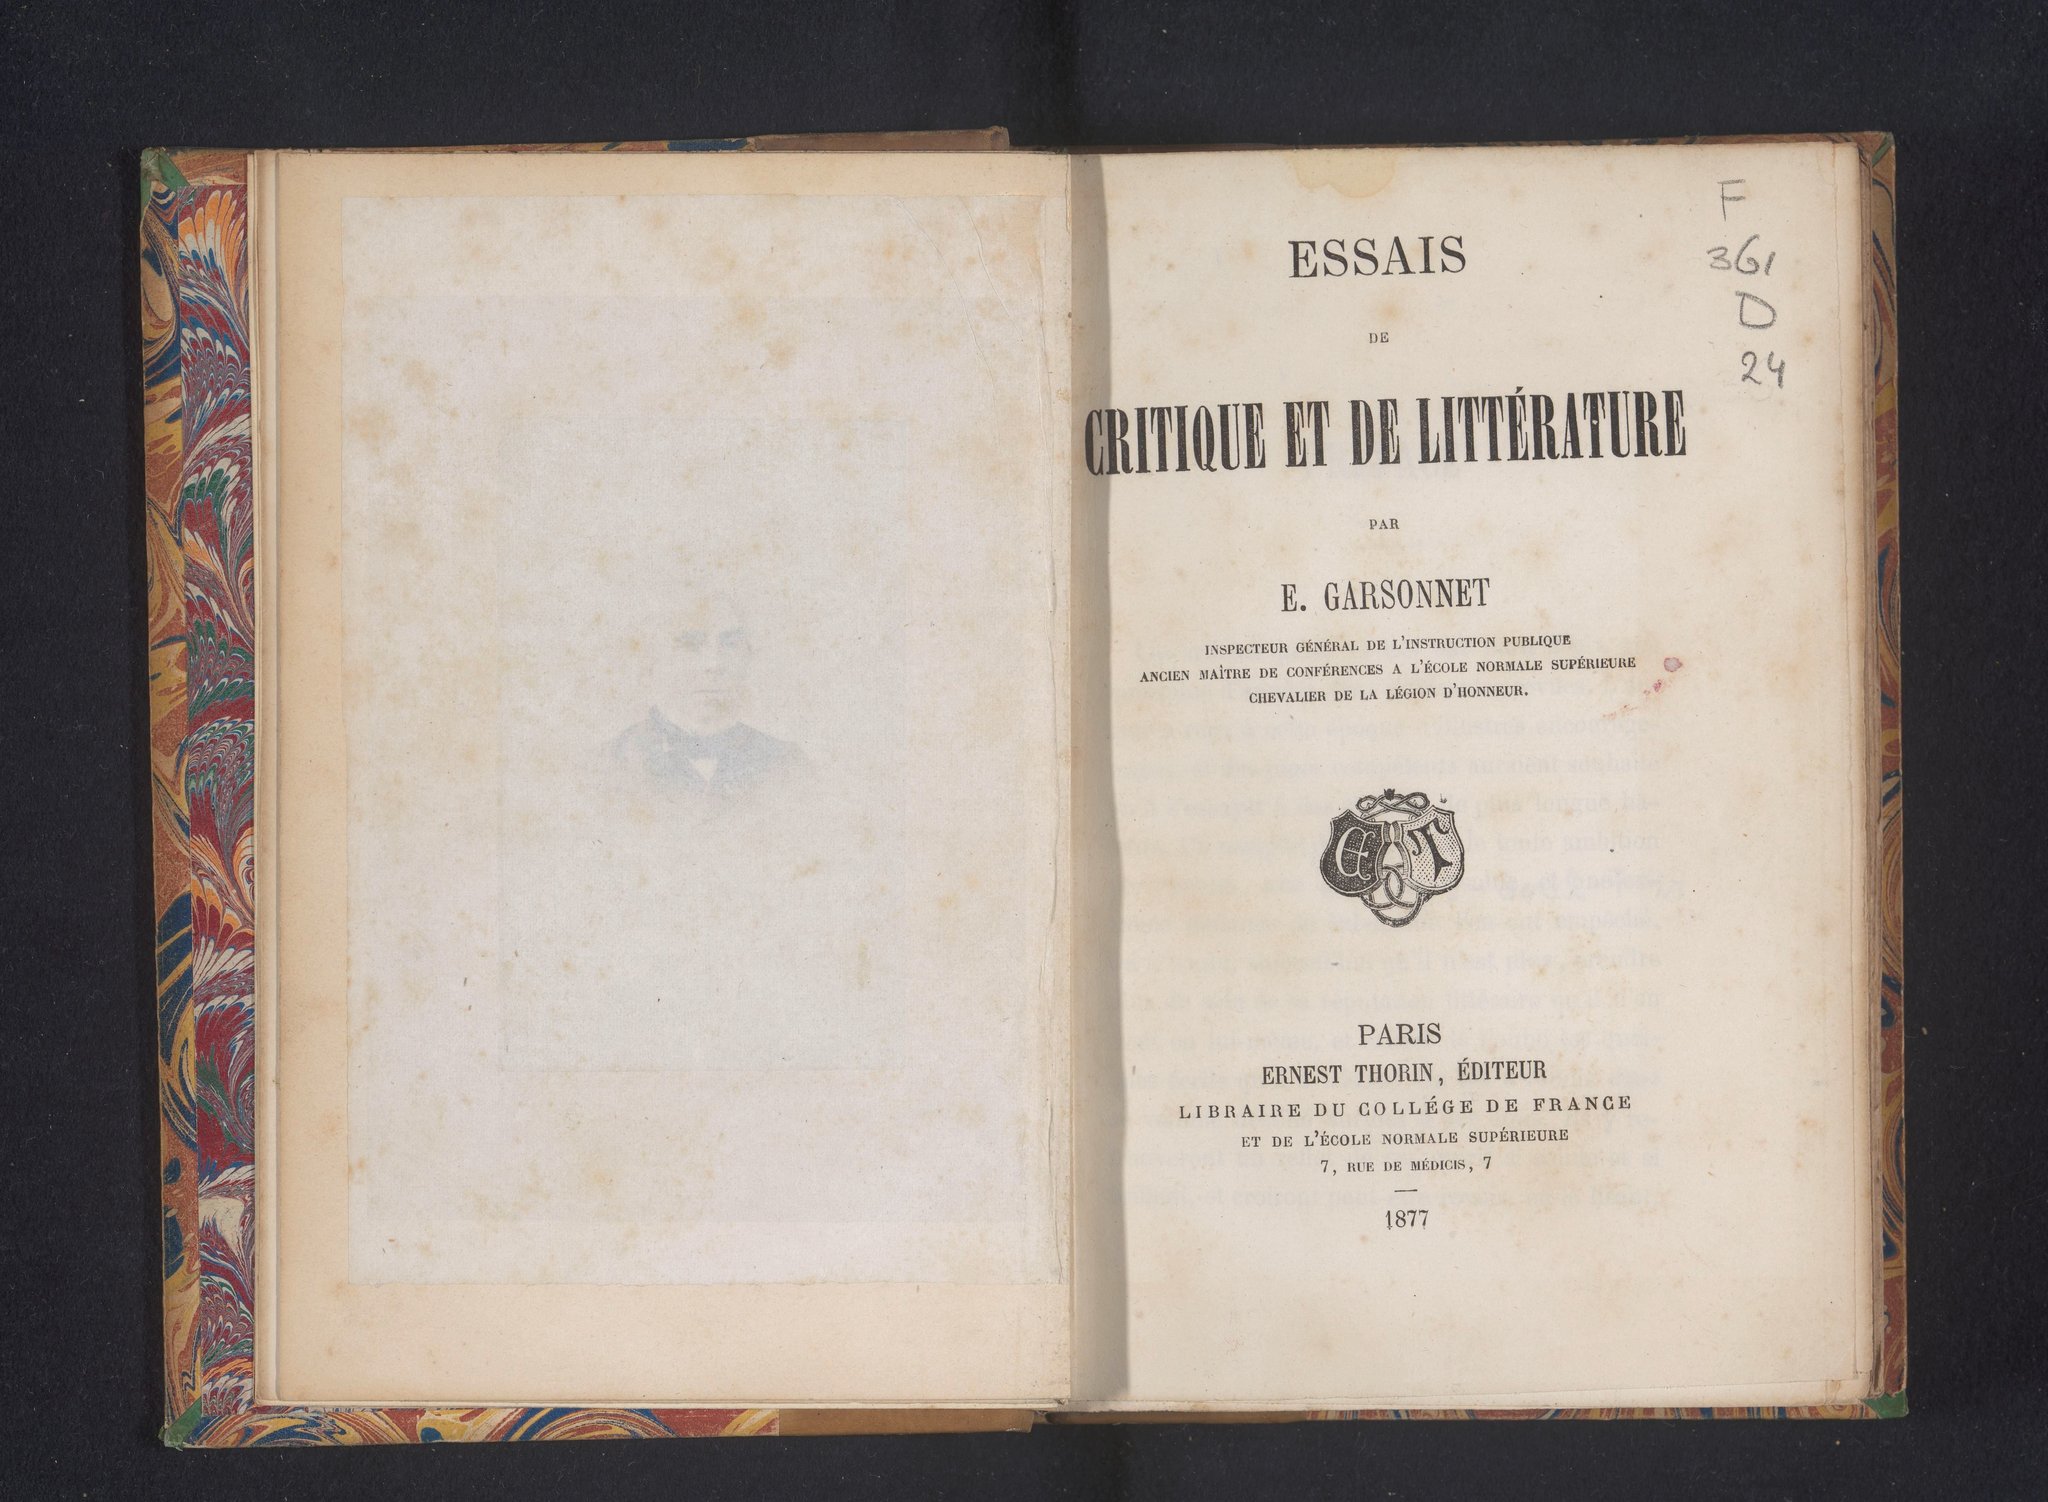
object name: book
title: Essais de critique et de littérature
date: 1877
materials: linen, paper, photographic support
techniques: albumen print, combed marbled paper, printing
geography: paris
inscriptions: date: ‘MAR 2006’